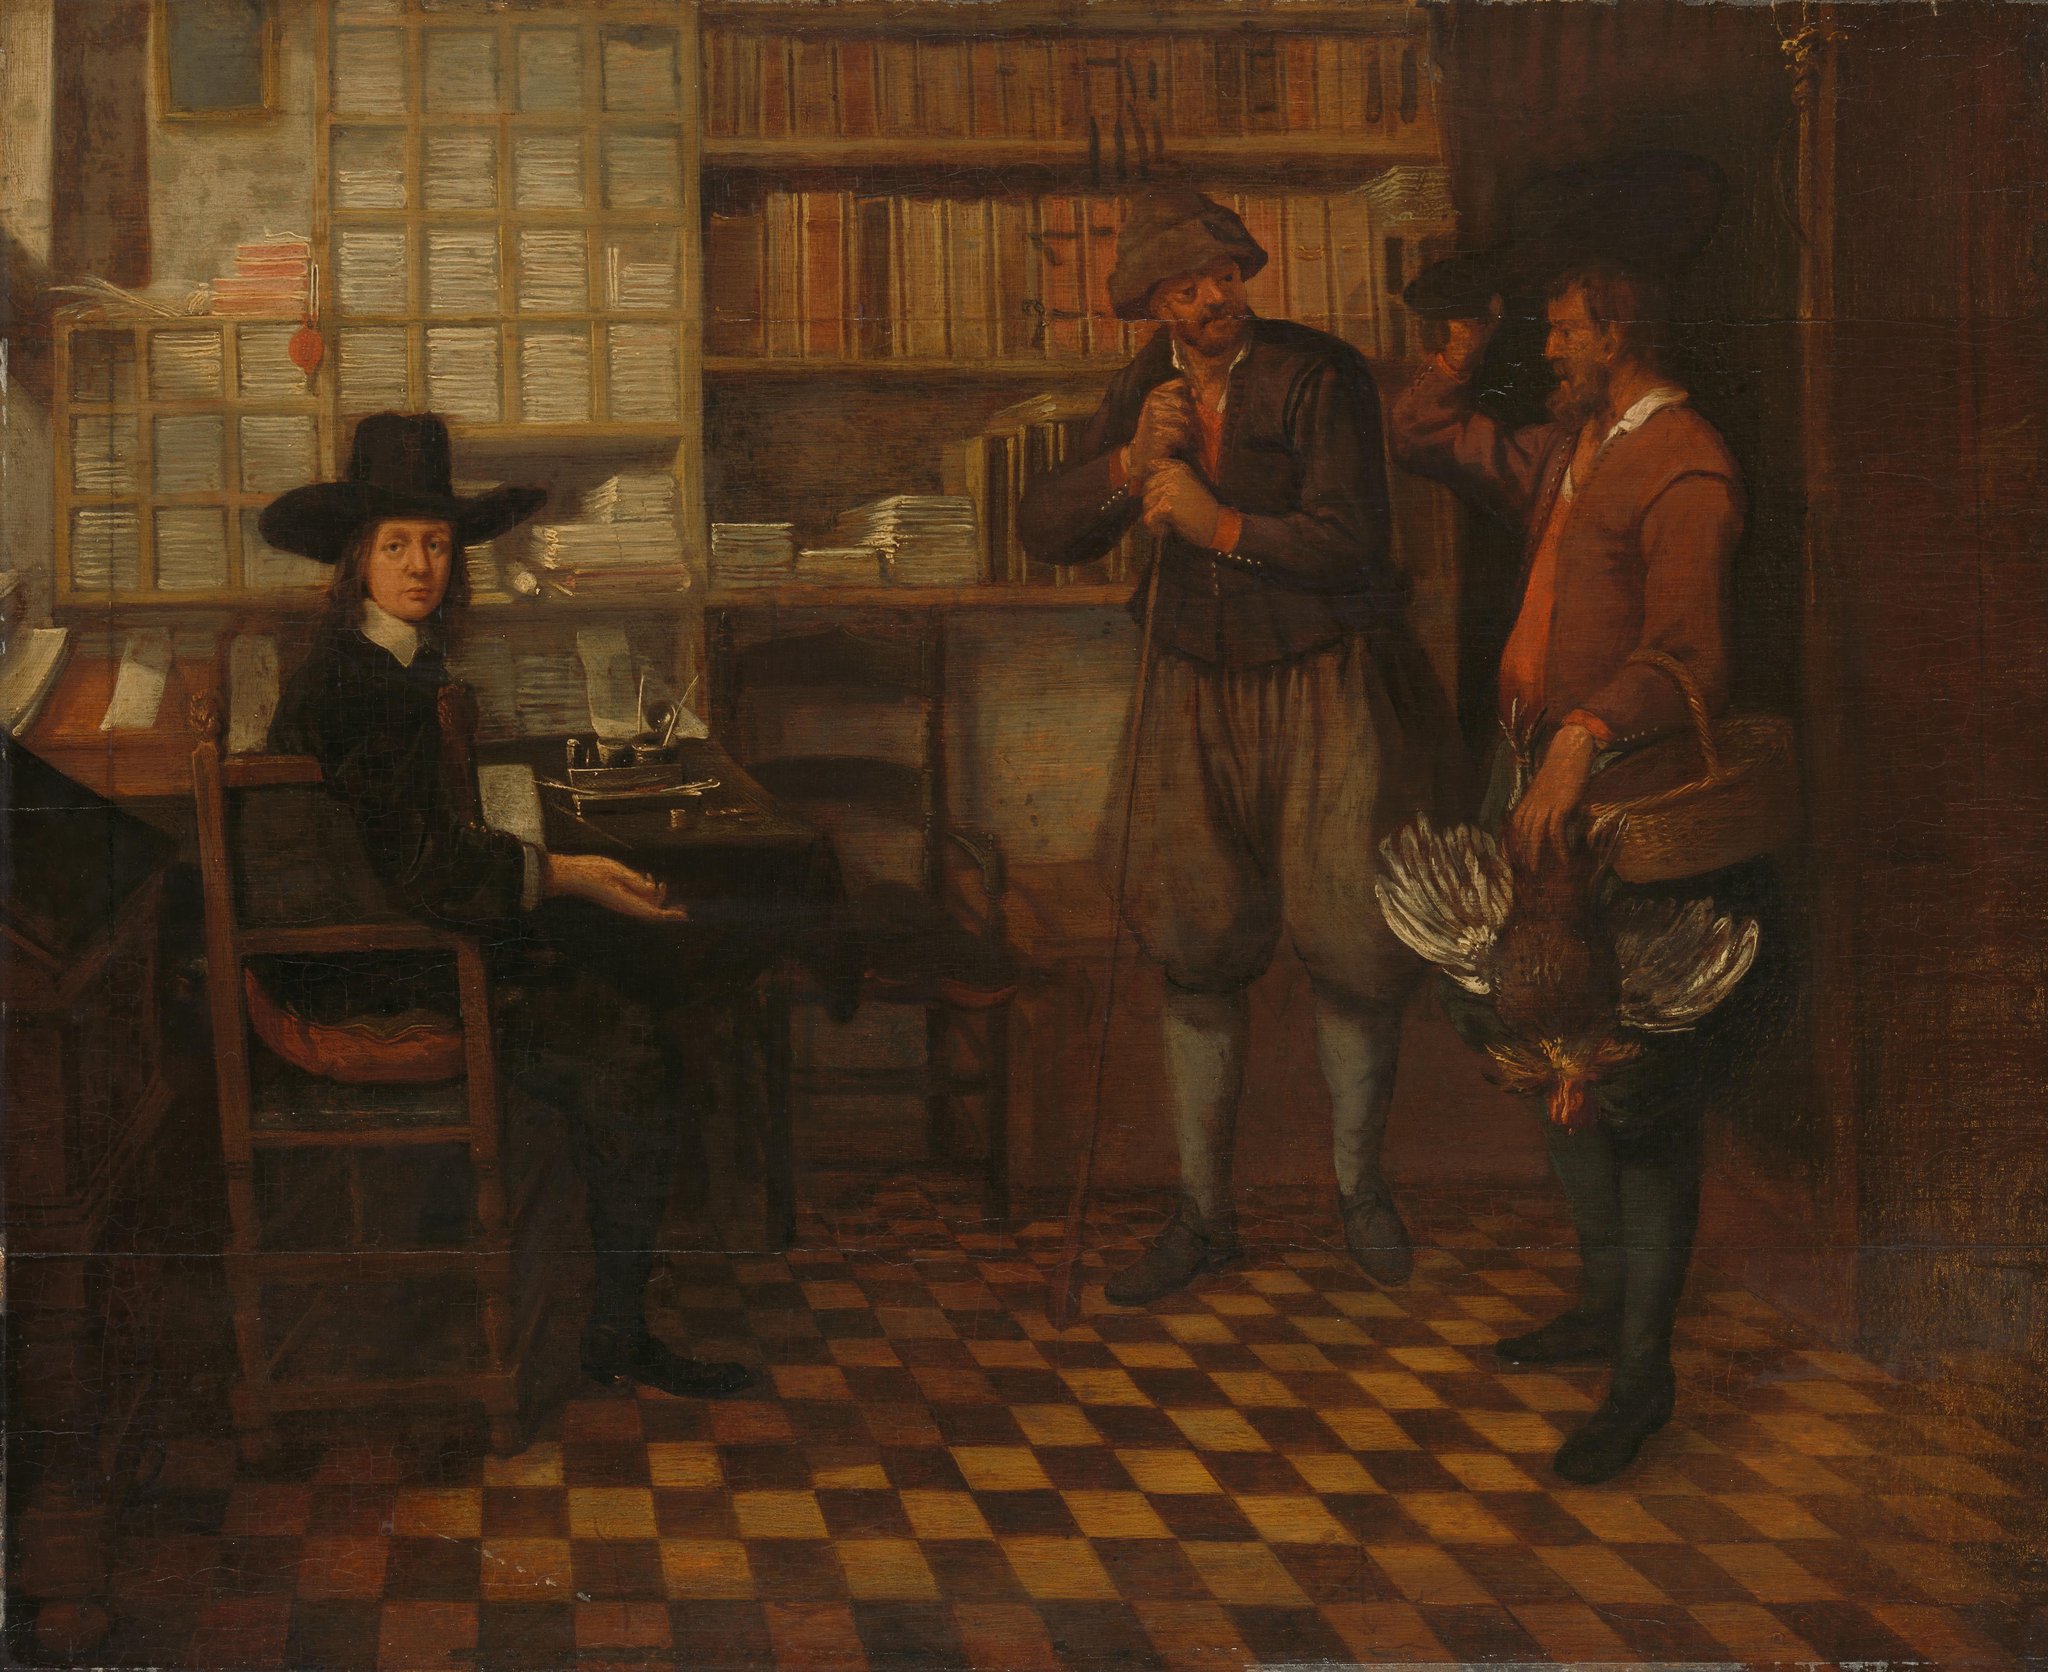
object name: painting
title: The Tenant Farmer's Rent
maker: quiringh gerritsz. van brekelenkam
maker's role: draughtsman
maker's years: 1622-1669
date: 1660-1668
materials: oil, panel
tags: tax payment, office (~ administration)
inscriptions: signature and date: ‘Q.B. 1662 (?)’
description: De pachtbetaling. Twee boeren in een kantoor om belasting of pacht in natura te betalen. De klerk zit aan zijn bureau en draait zich om. Tegen de muur kasten met acten en boeken. De boer rechts heeft een kip bij zich, de ander leunt op zijn stok.